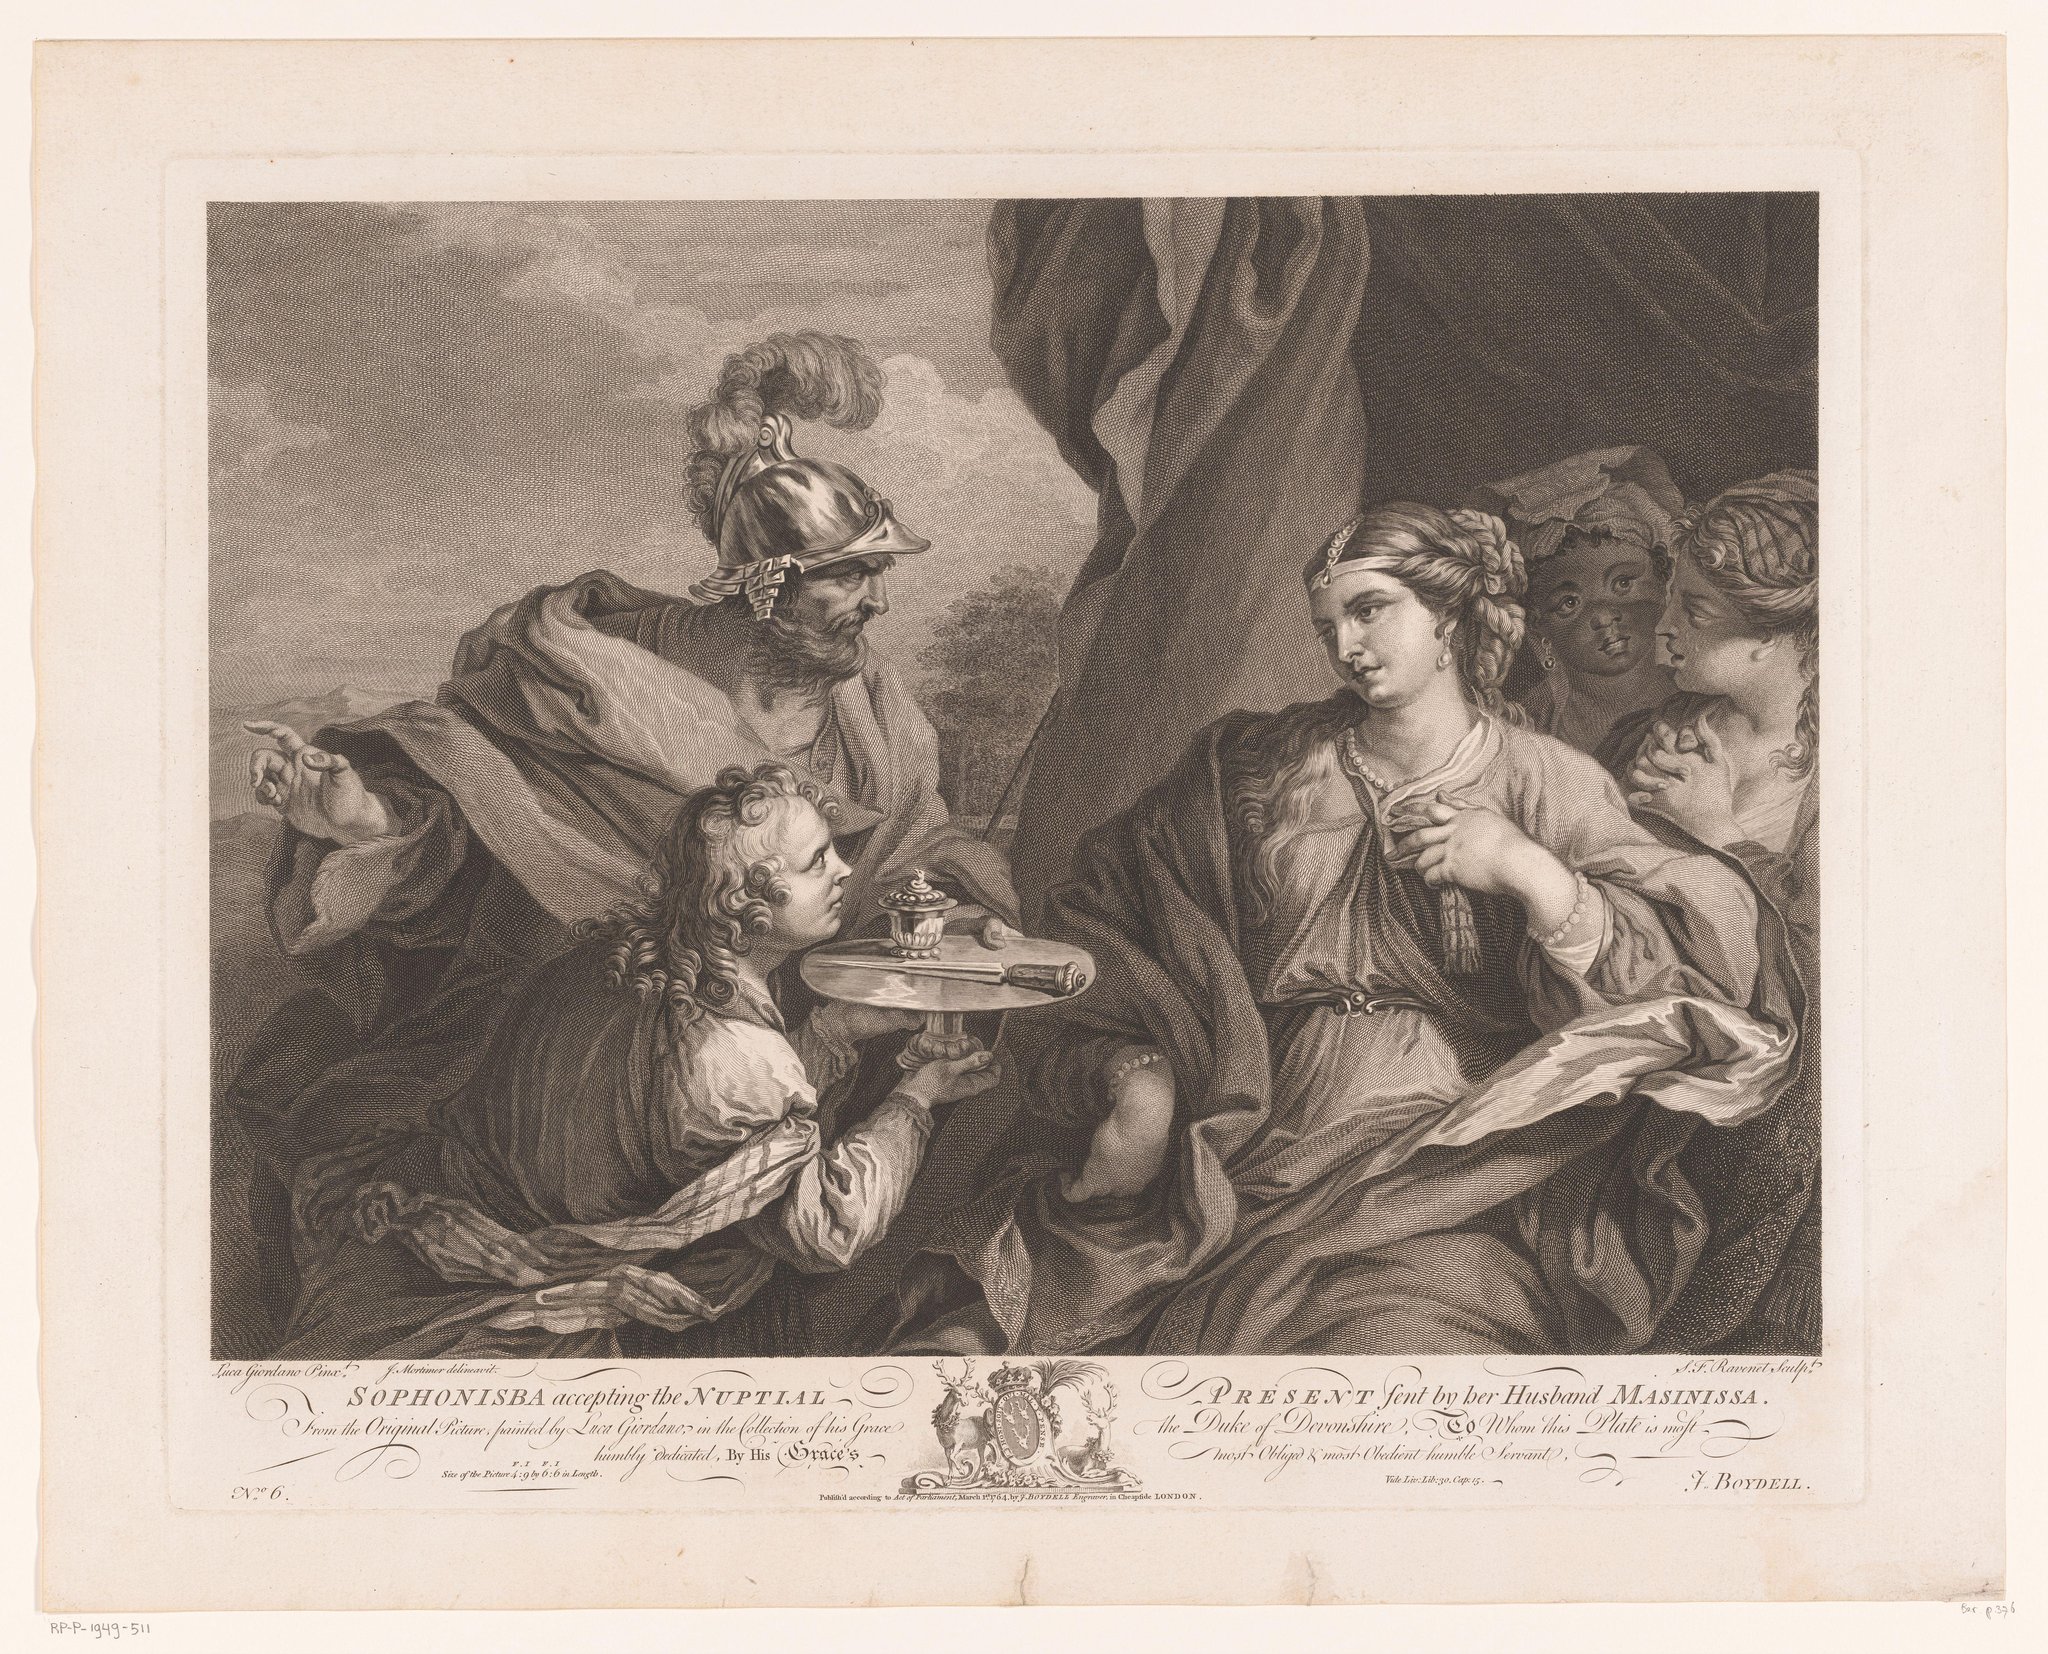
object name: print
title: Sophonisba ontvangt het huwelijksgeschenk van Masinissa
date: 1764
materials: paper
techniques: engraving, etching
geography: london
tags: death of sophonisbe: she receives from a servant a cup of poison sent to her by masinissa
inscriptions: collector's mark: Lugt 2228